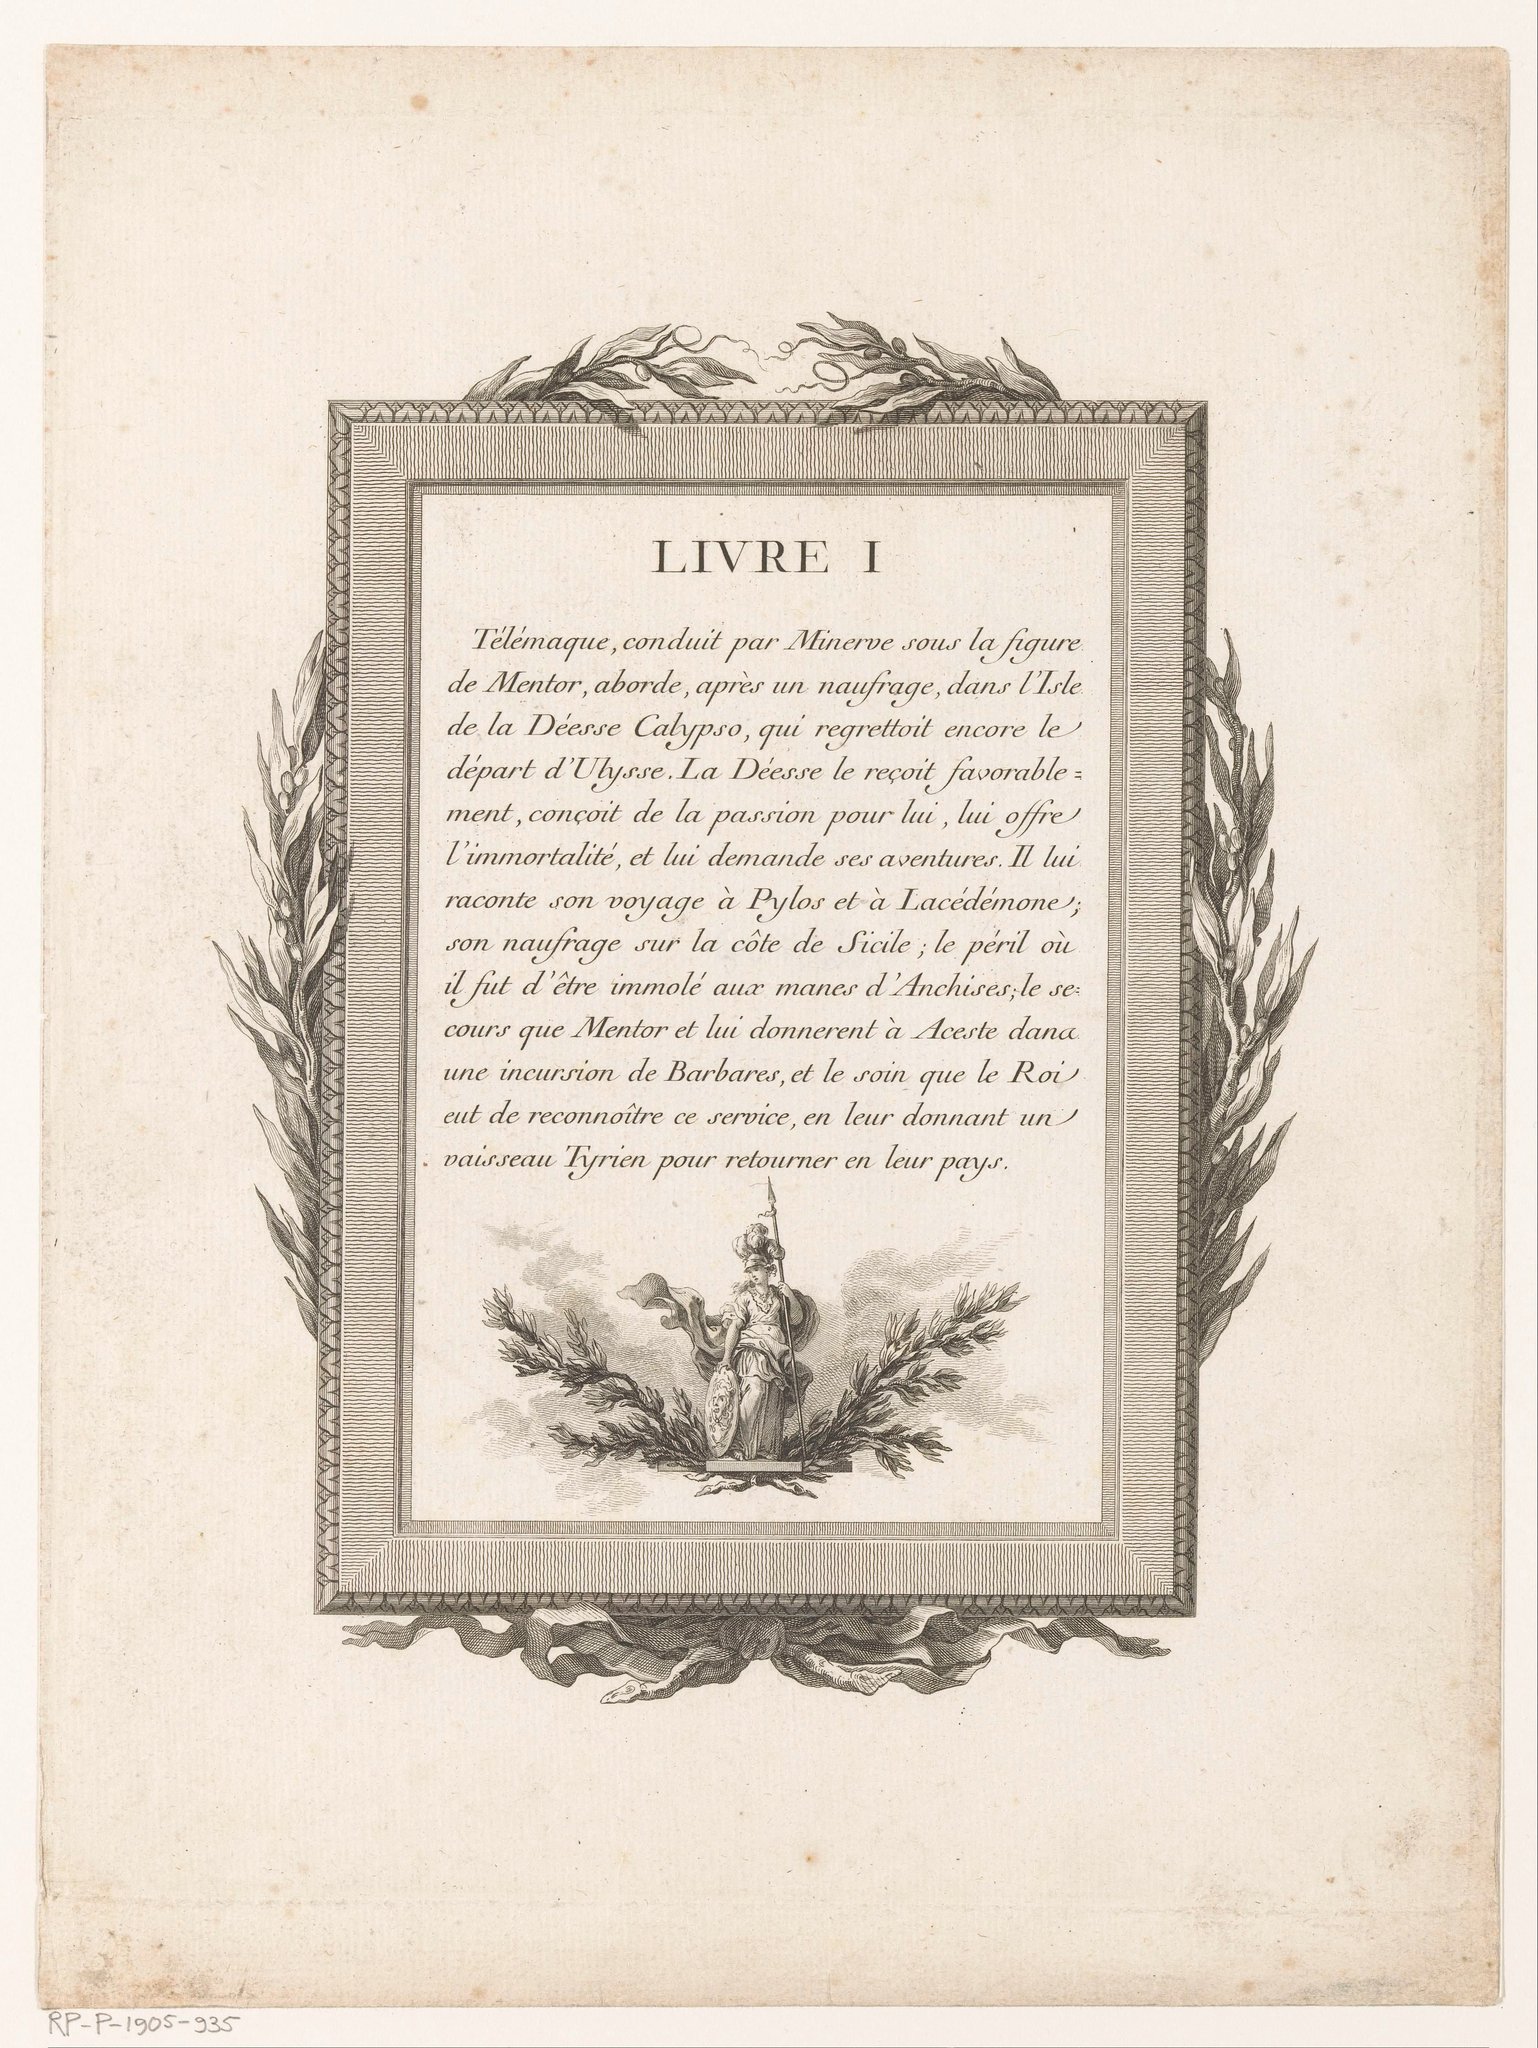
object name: book illustration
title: Omkaderde Franse tekst met Athena en olijftakken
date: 1785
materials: paper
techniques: engraving, etching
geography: paris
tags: (fenelon, telemachus) specific works of literature (with author, title), specific aspects, allegorical aspects of minerva; minerva as patroness, ornament ~ festoon, garland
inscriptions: collector's mark: Lugt 2228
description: Dertienregelige Franse tekst, getiteld 'Livre I' met daaronder een afbeelding van de godin Athena. De tekst wordt gekaderd door een sierlijst met olijftakken en onderaan een strik.